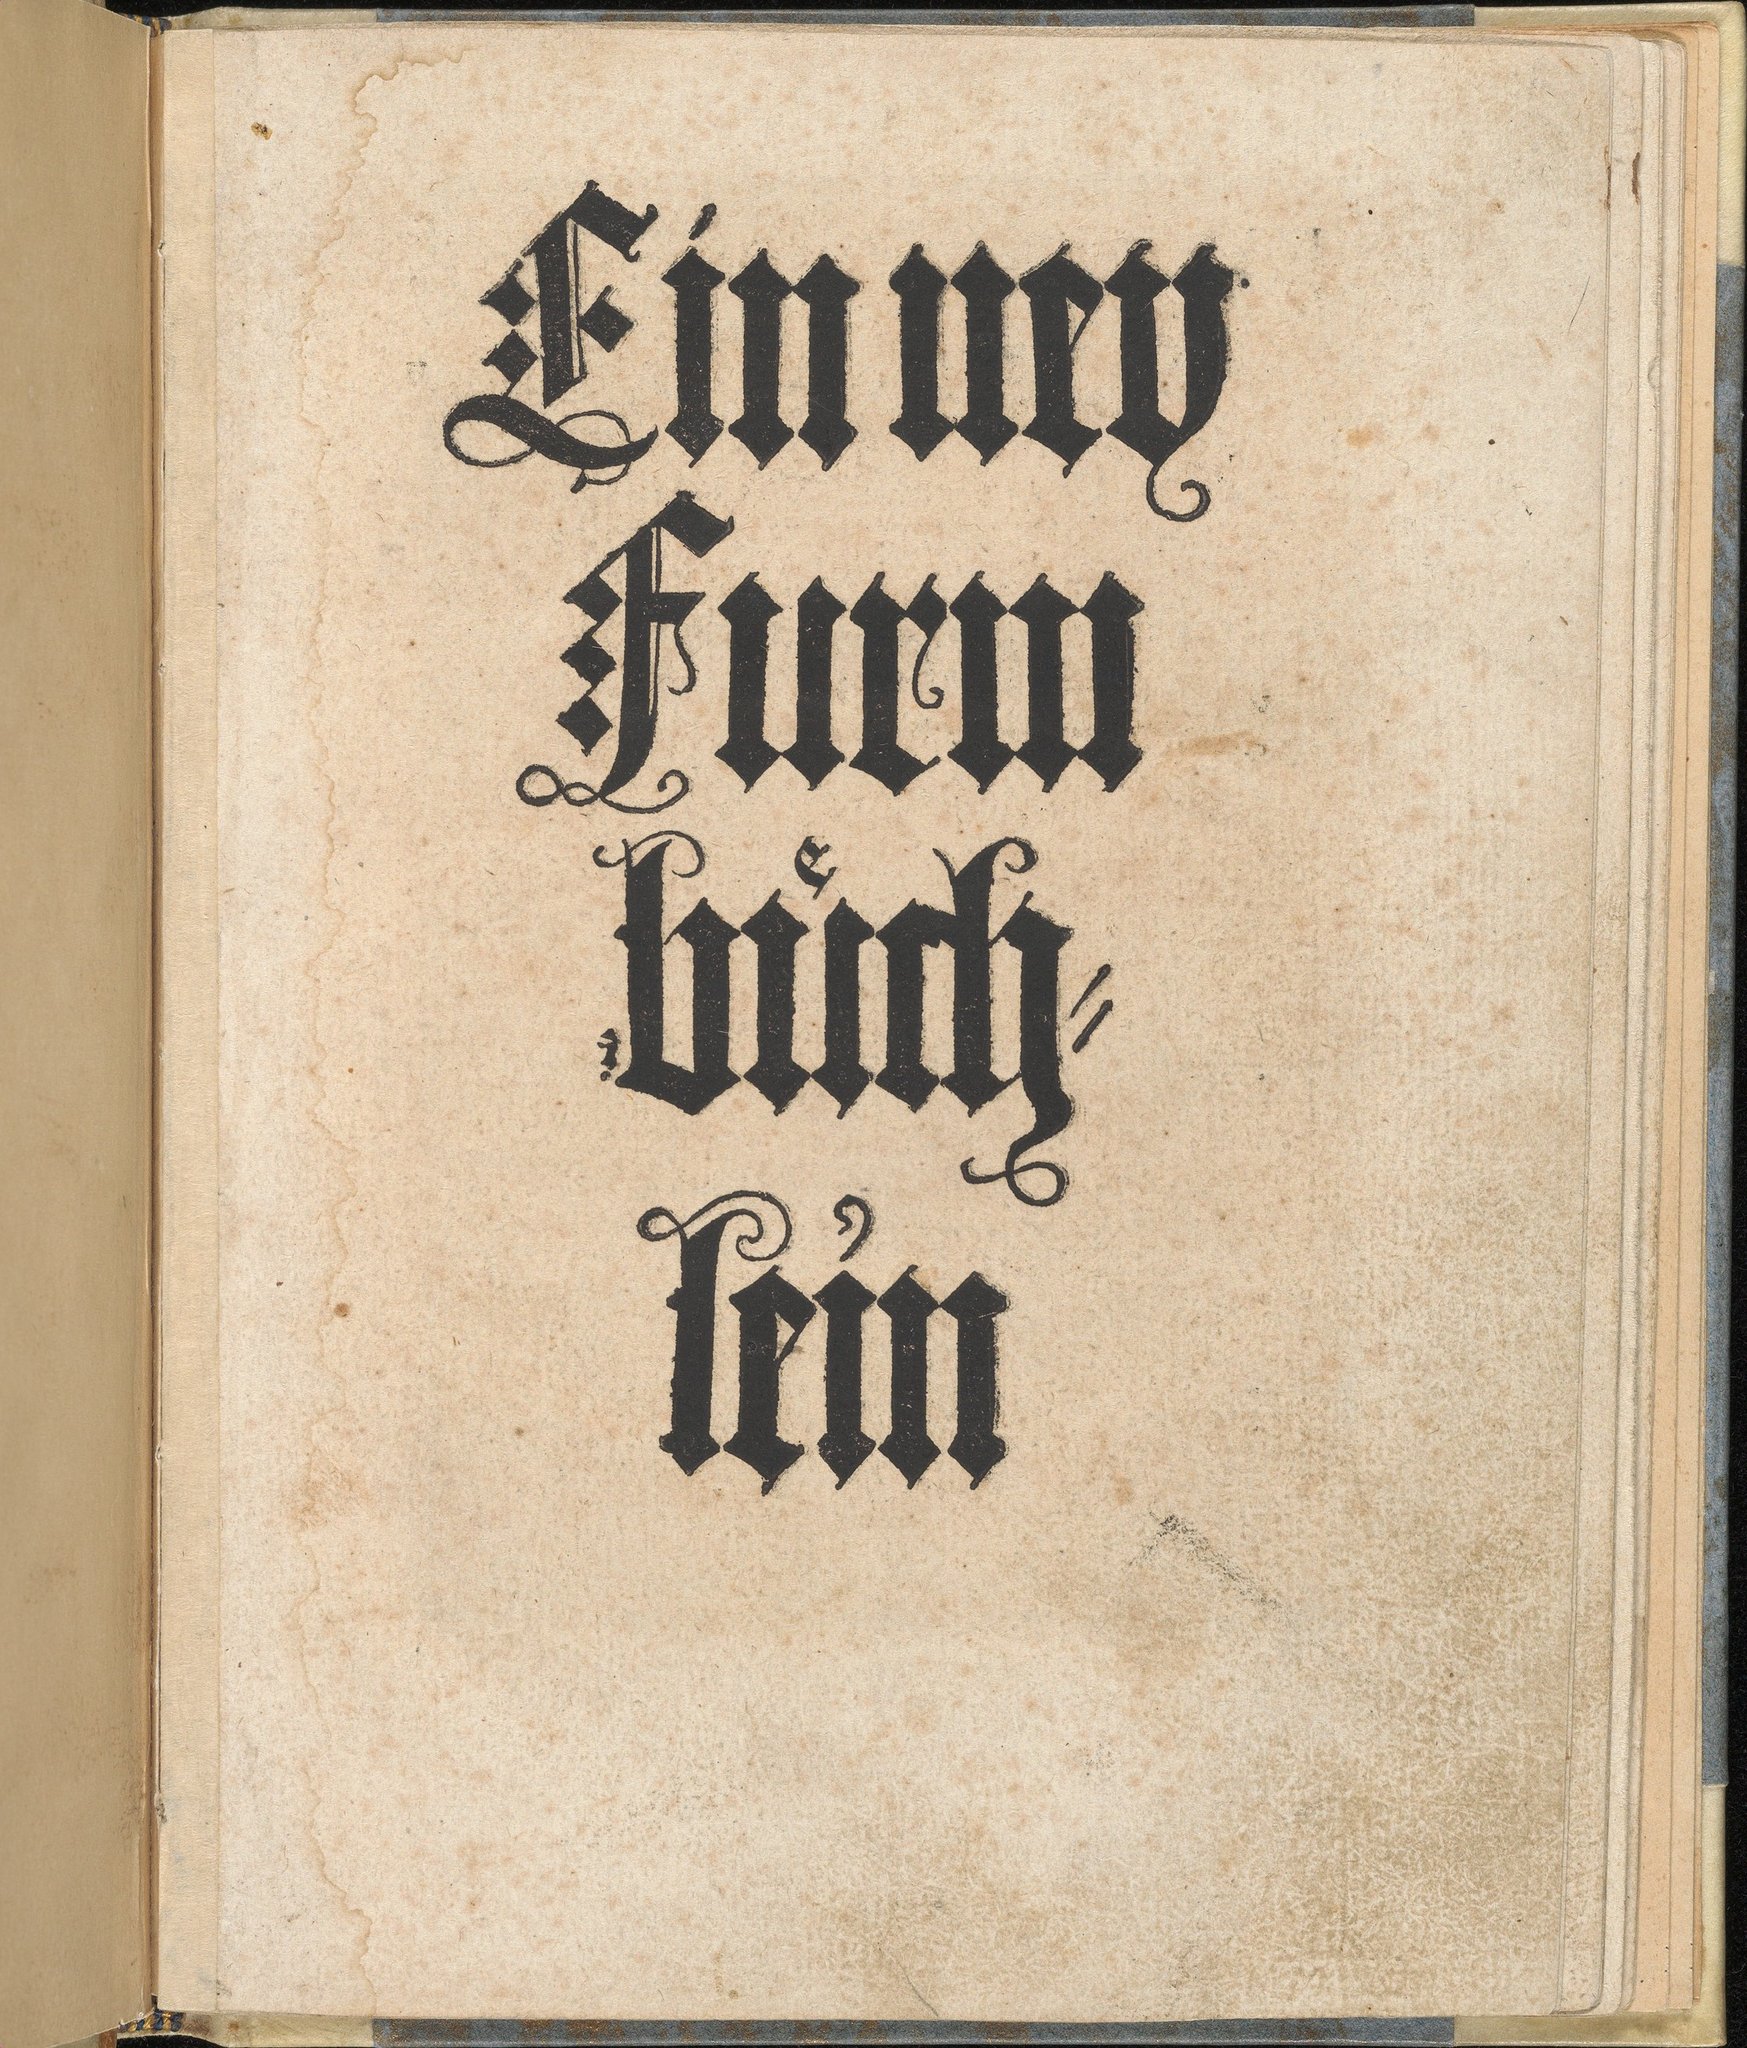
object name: book print ornament architecture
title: Ein ney Furmbüchlein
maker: johann schönsperger the younger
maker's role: publisher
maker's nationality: german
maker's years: 1490-1550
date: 1525-1529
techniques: woodcut